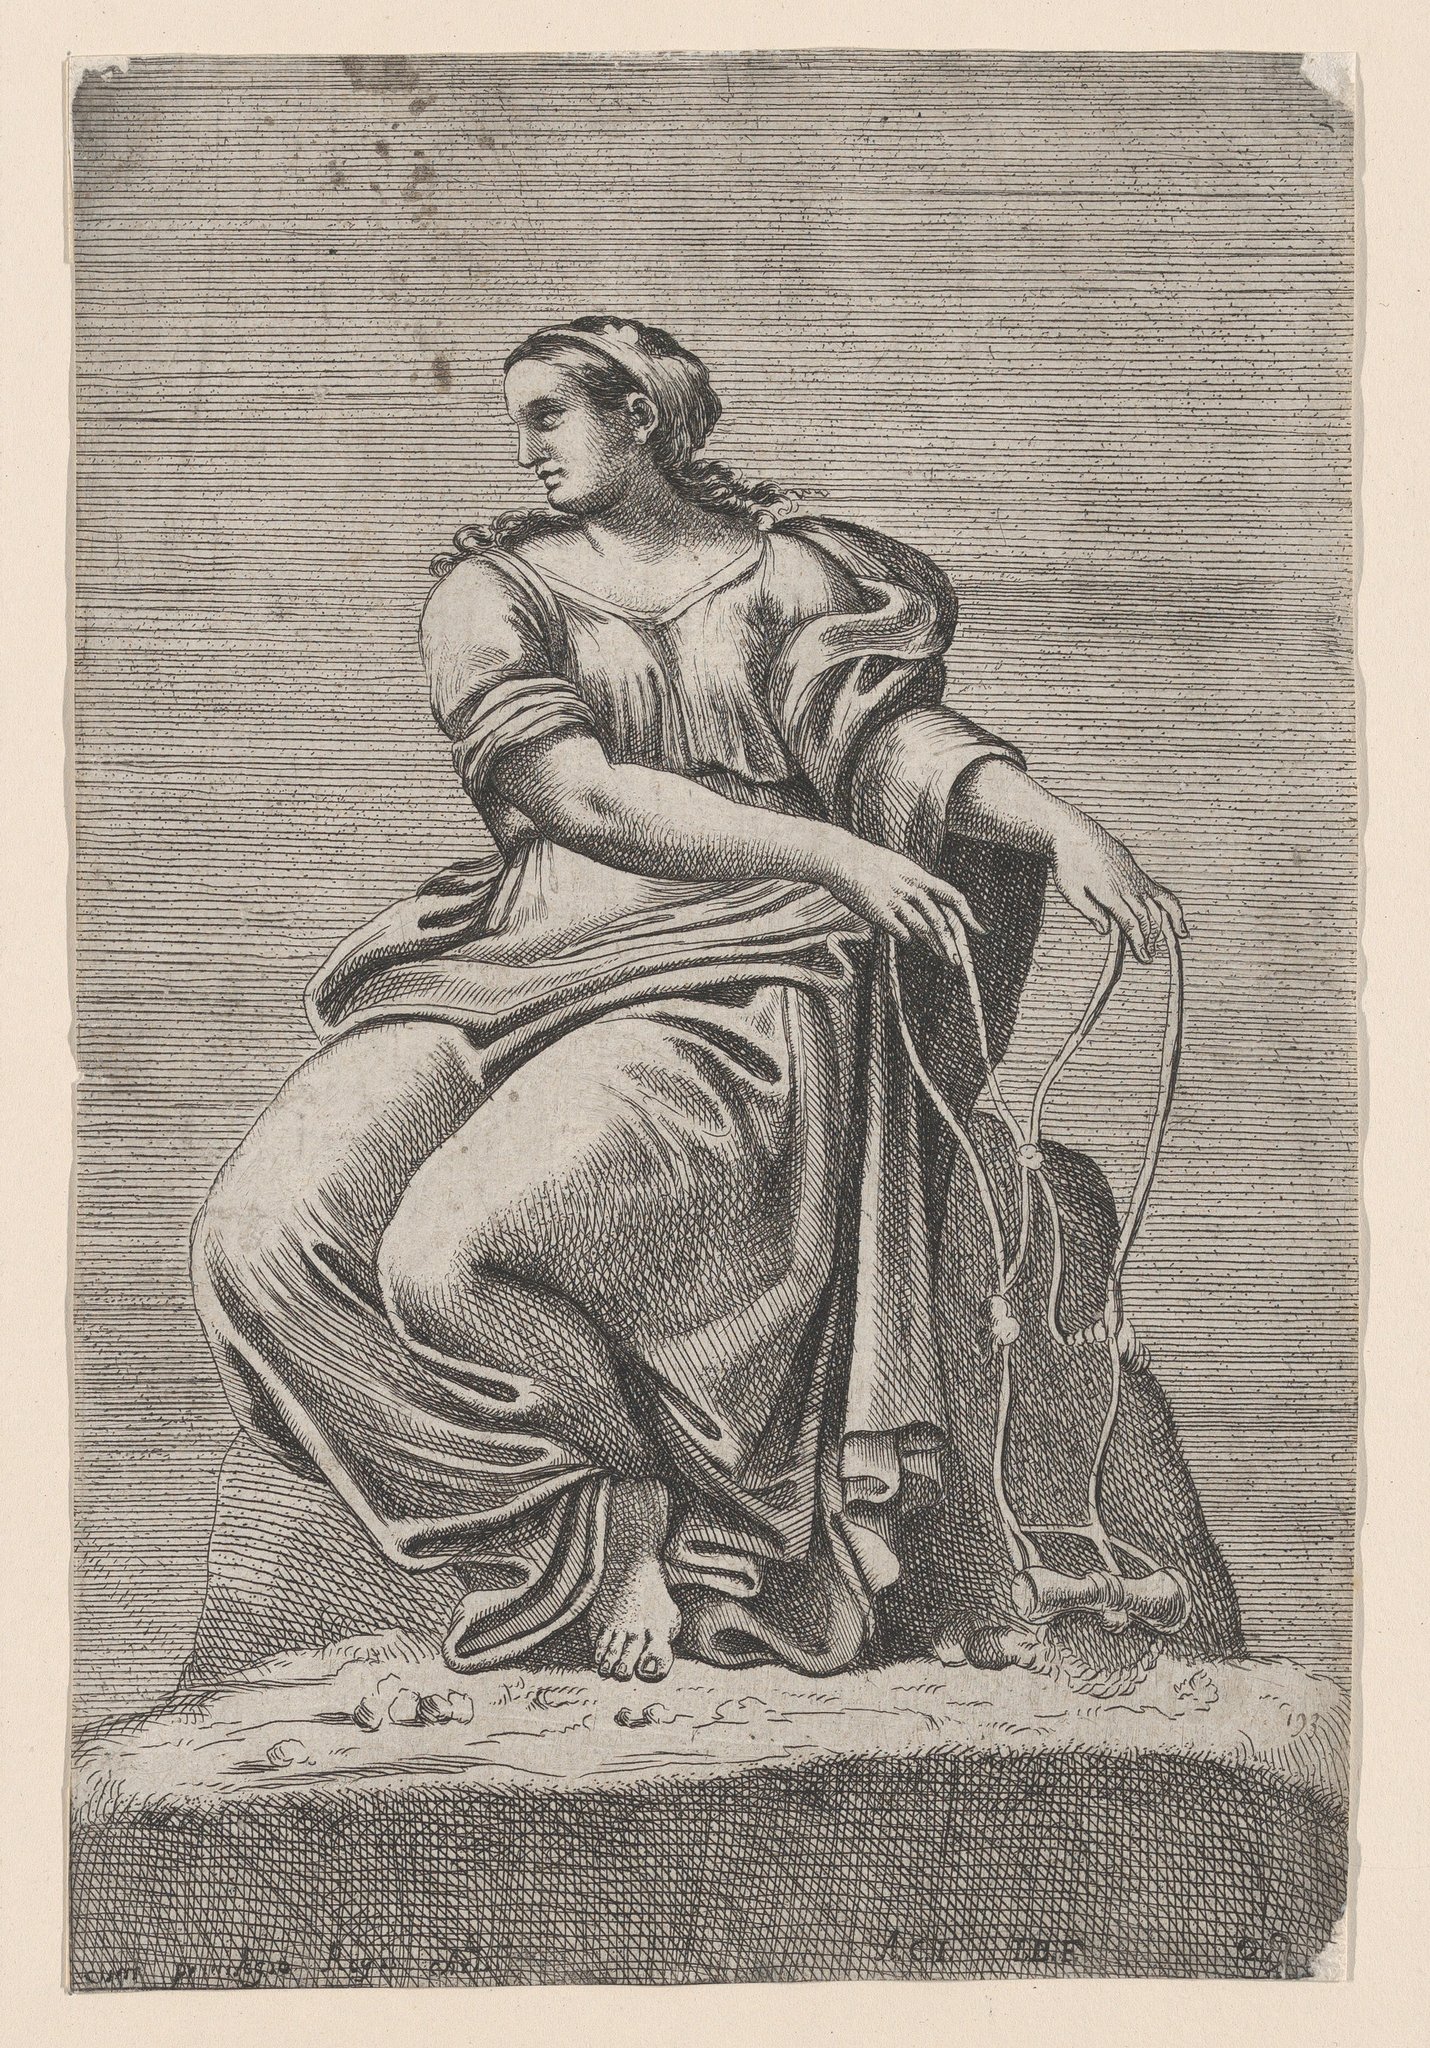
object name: print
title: Seated Figure of Justice, from Farnese Palace, after Annibale and Agostino Carracci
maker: jacques belly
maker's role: artist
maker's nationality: french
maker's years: 1609-1674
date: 1641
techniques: etching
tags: profiles,women